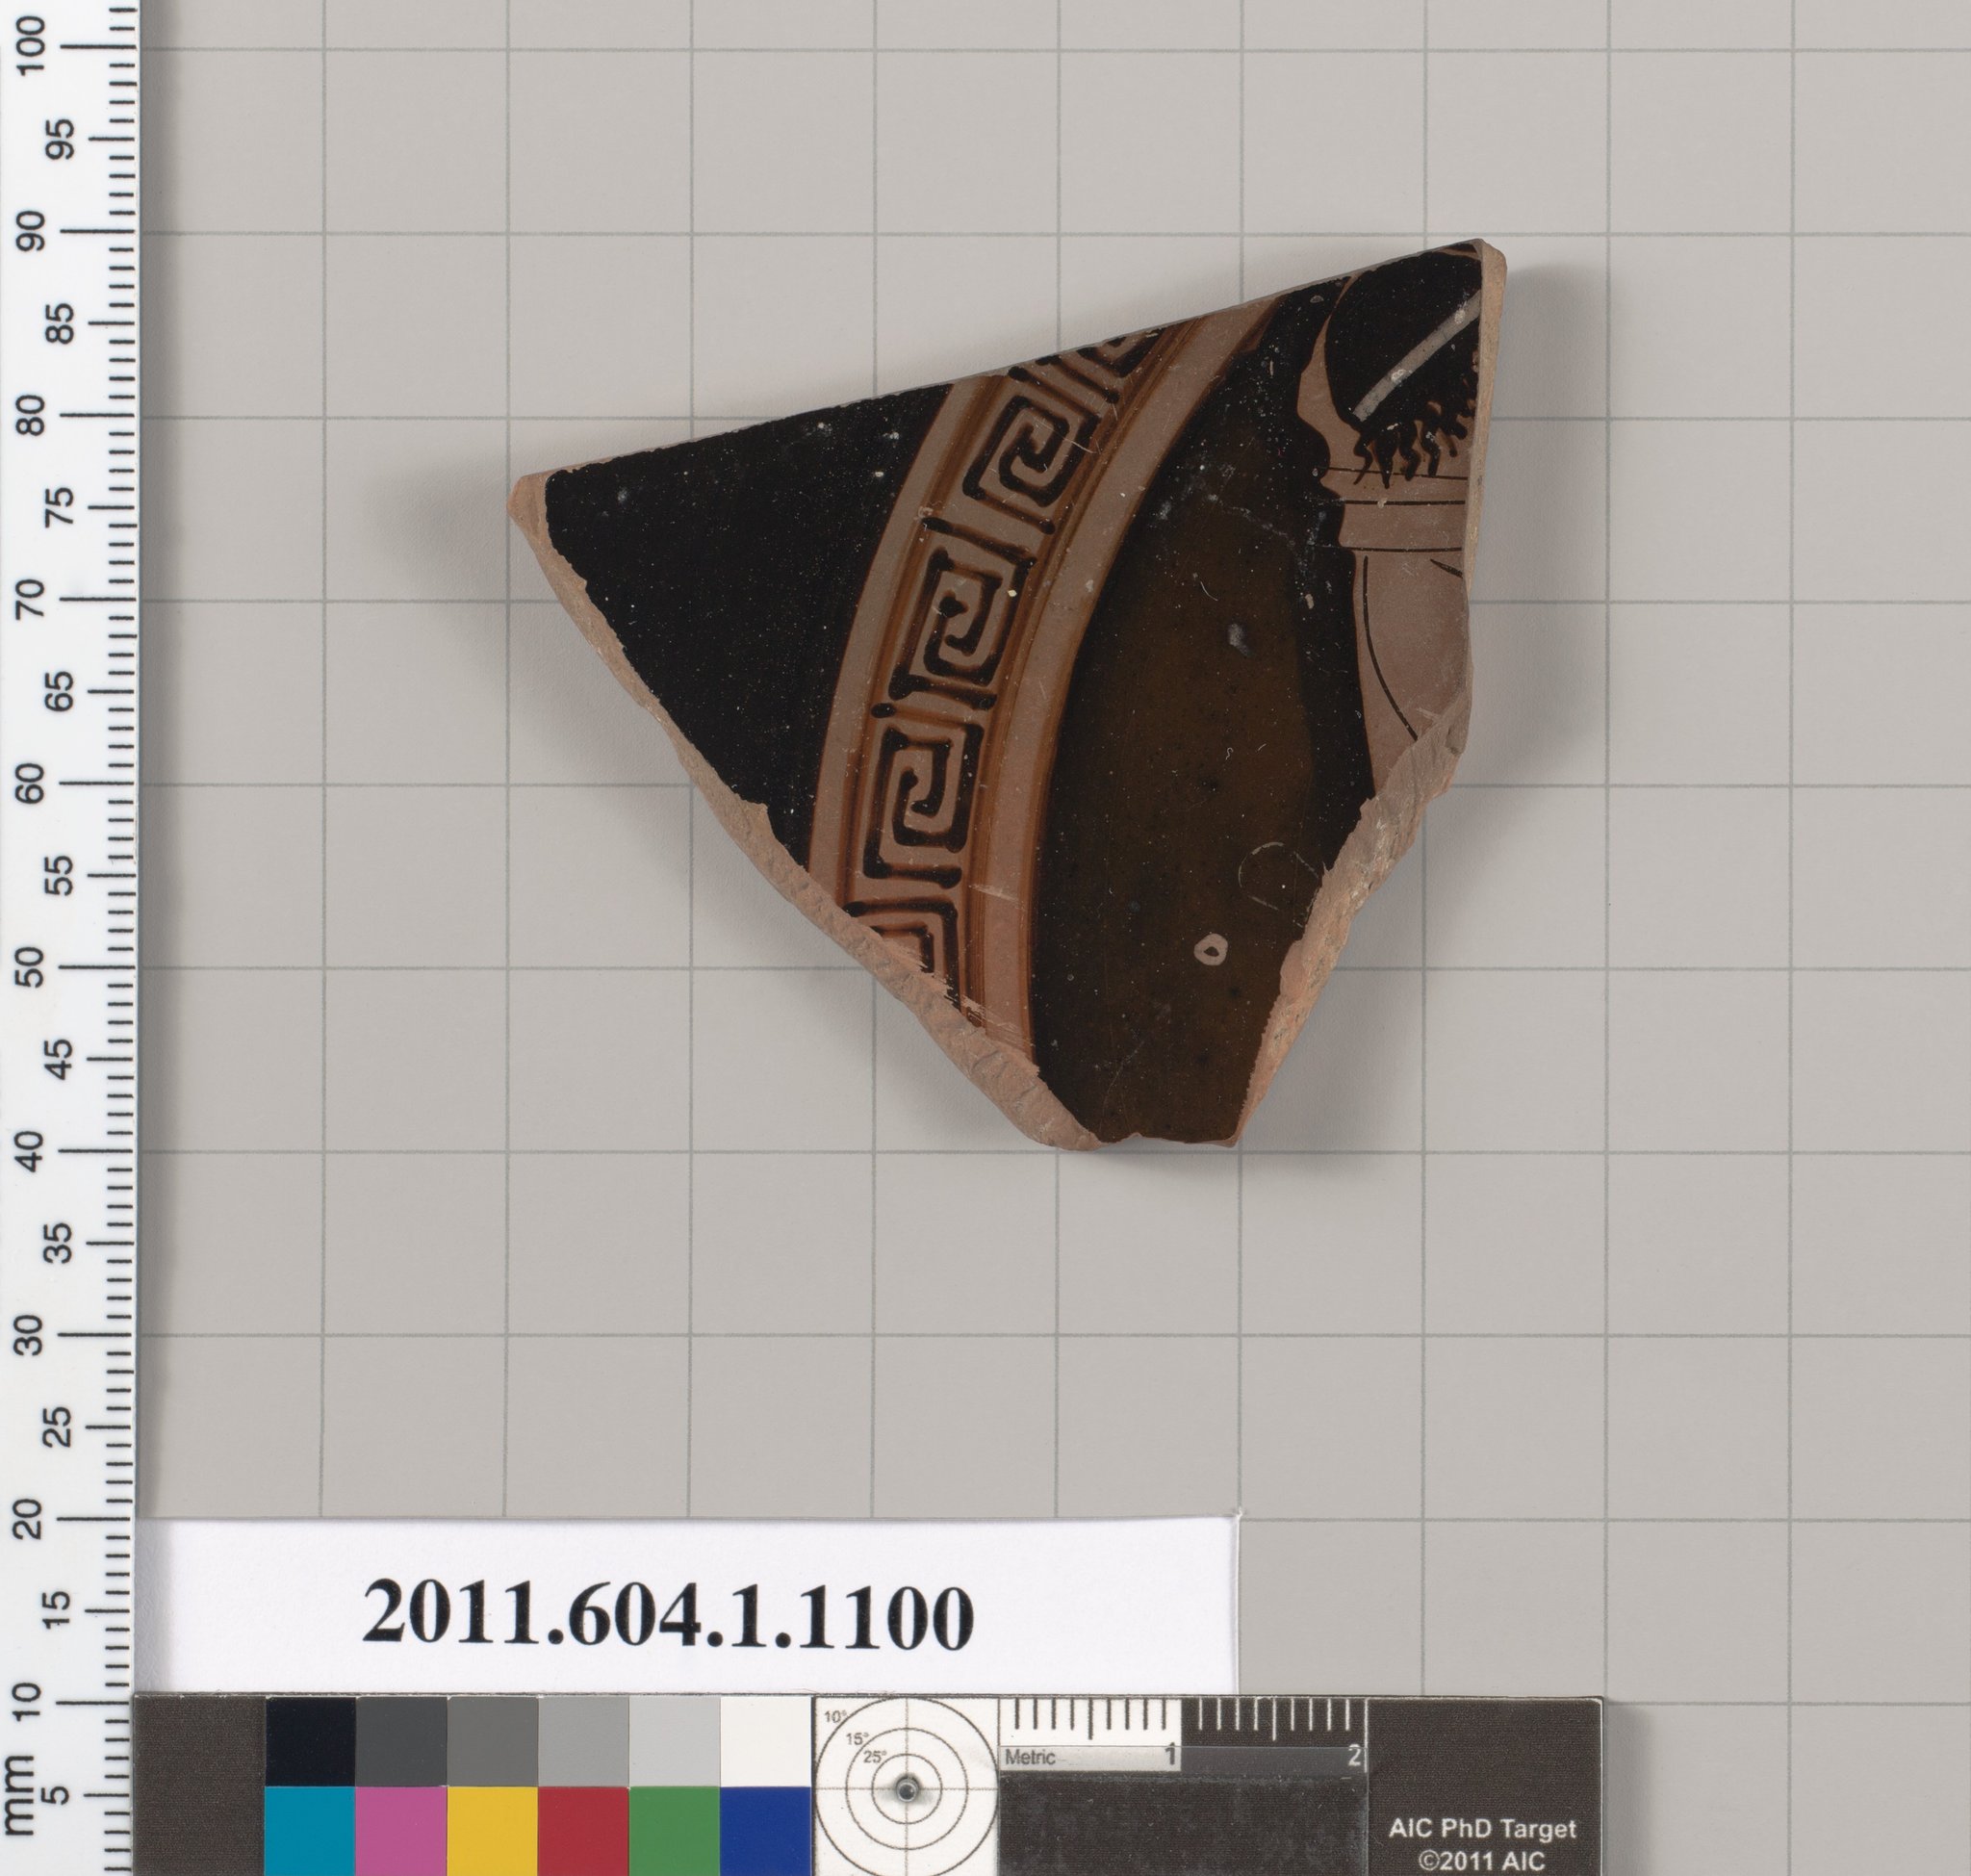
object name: kylix fragment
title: Terracotta fragment of a kylix (drinking cup)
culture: greek, attic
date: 475-451 BCE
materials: terracotta